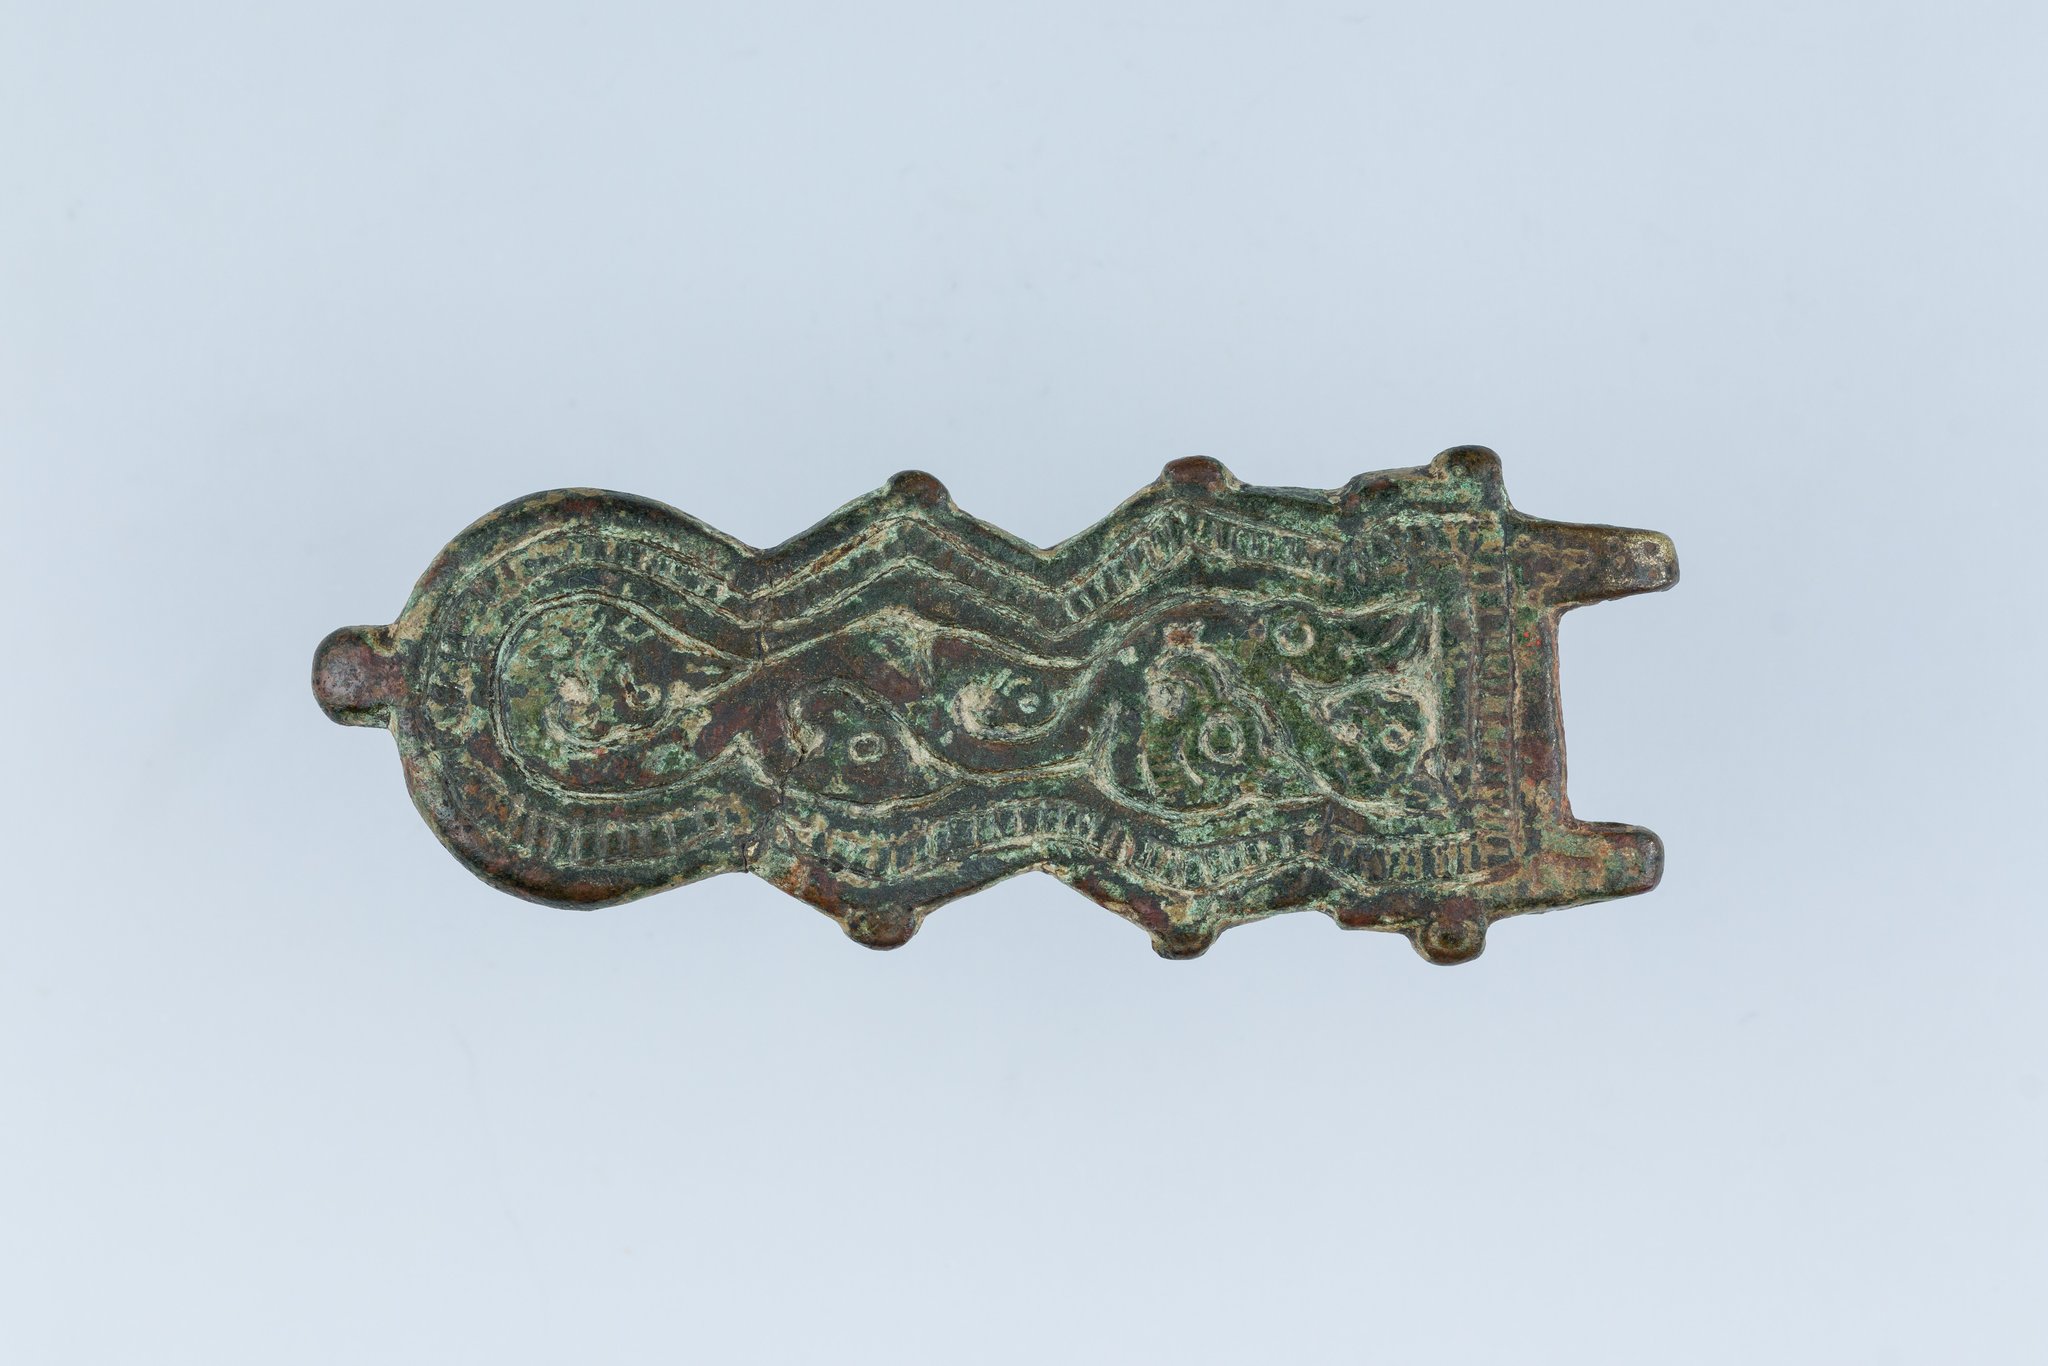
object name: buckle shank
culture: visigothic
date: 601-700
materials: copper alloy, tin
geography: spain or portugal